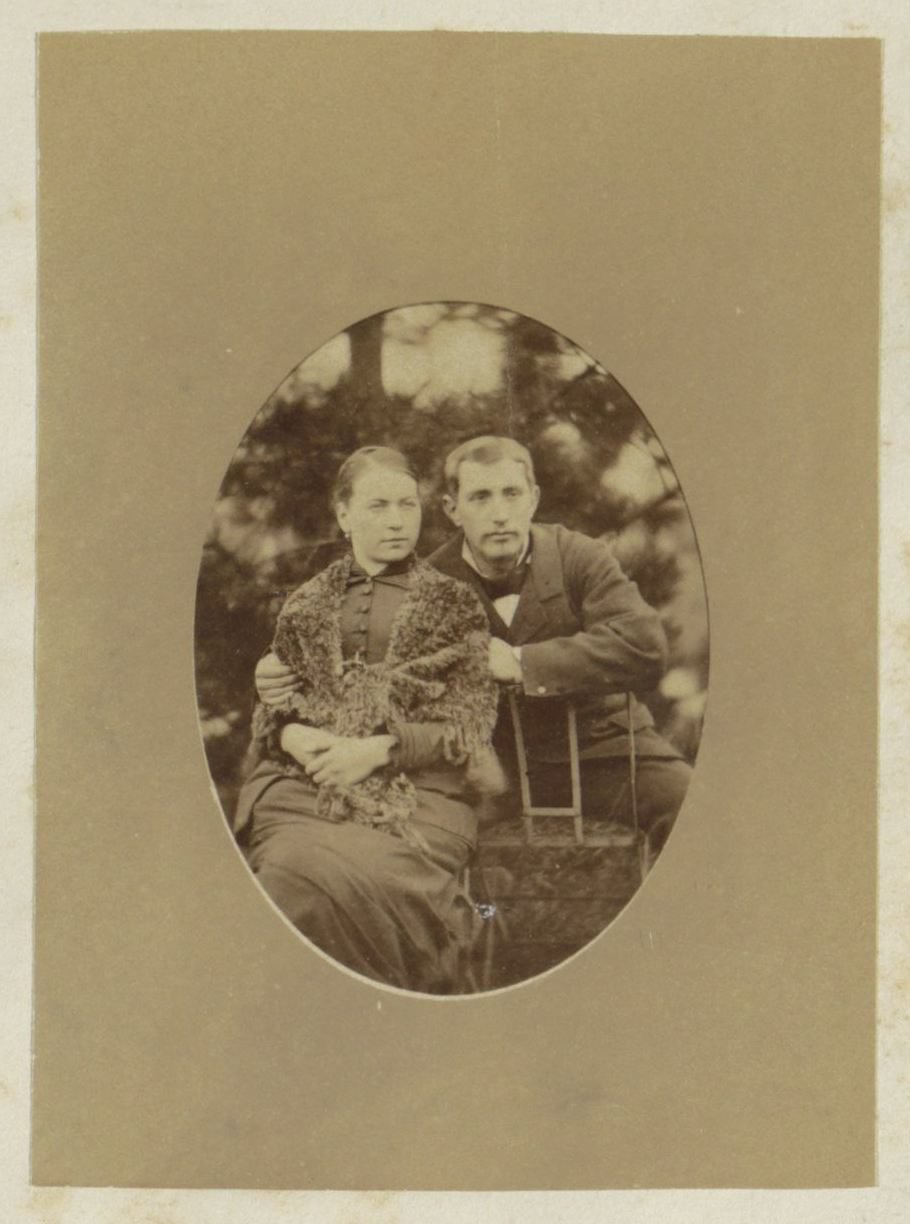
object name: photograph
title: Portret van een Frans stel, zittend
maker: Anonymous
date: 1883-1886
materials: photographic support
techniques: albumen print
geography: france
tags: marriage, married couple, 'matrimonium', france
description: Onderdeel van Album van een Franse amateurfotograaf met opnames van familie, militairen, industrie, landschappen en bezienswaardigheden in Frankrijk.